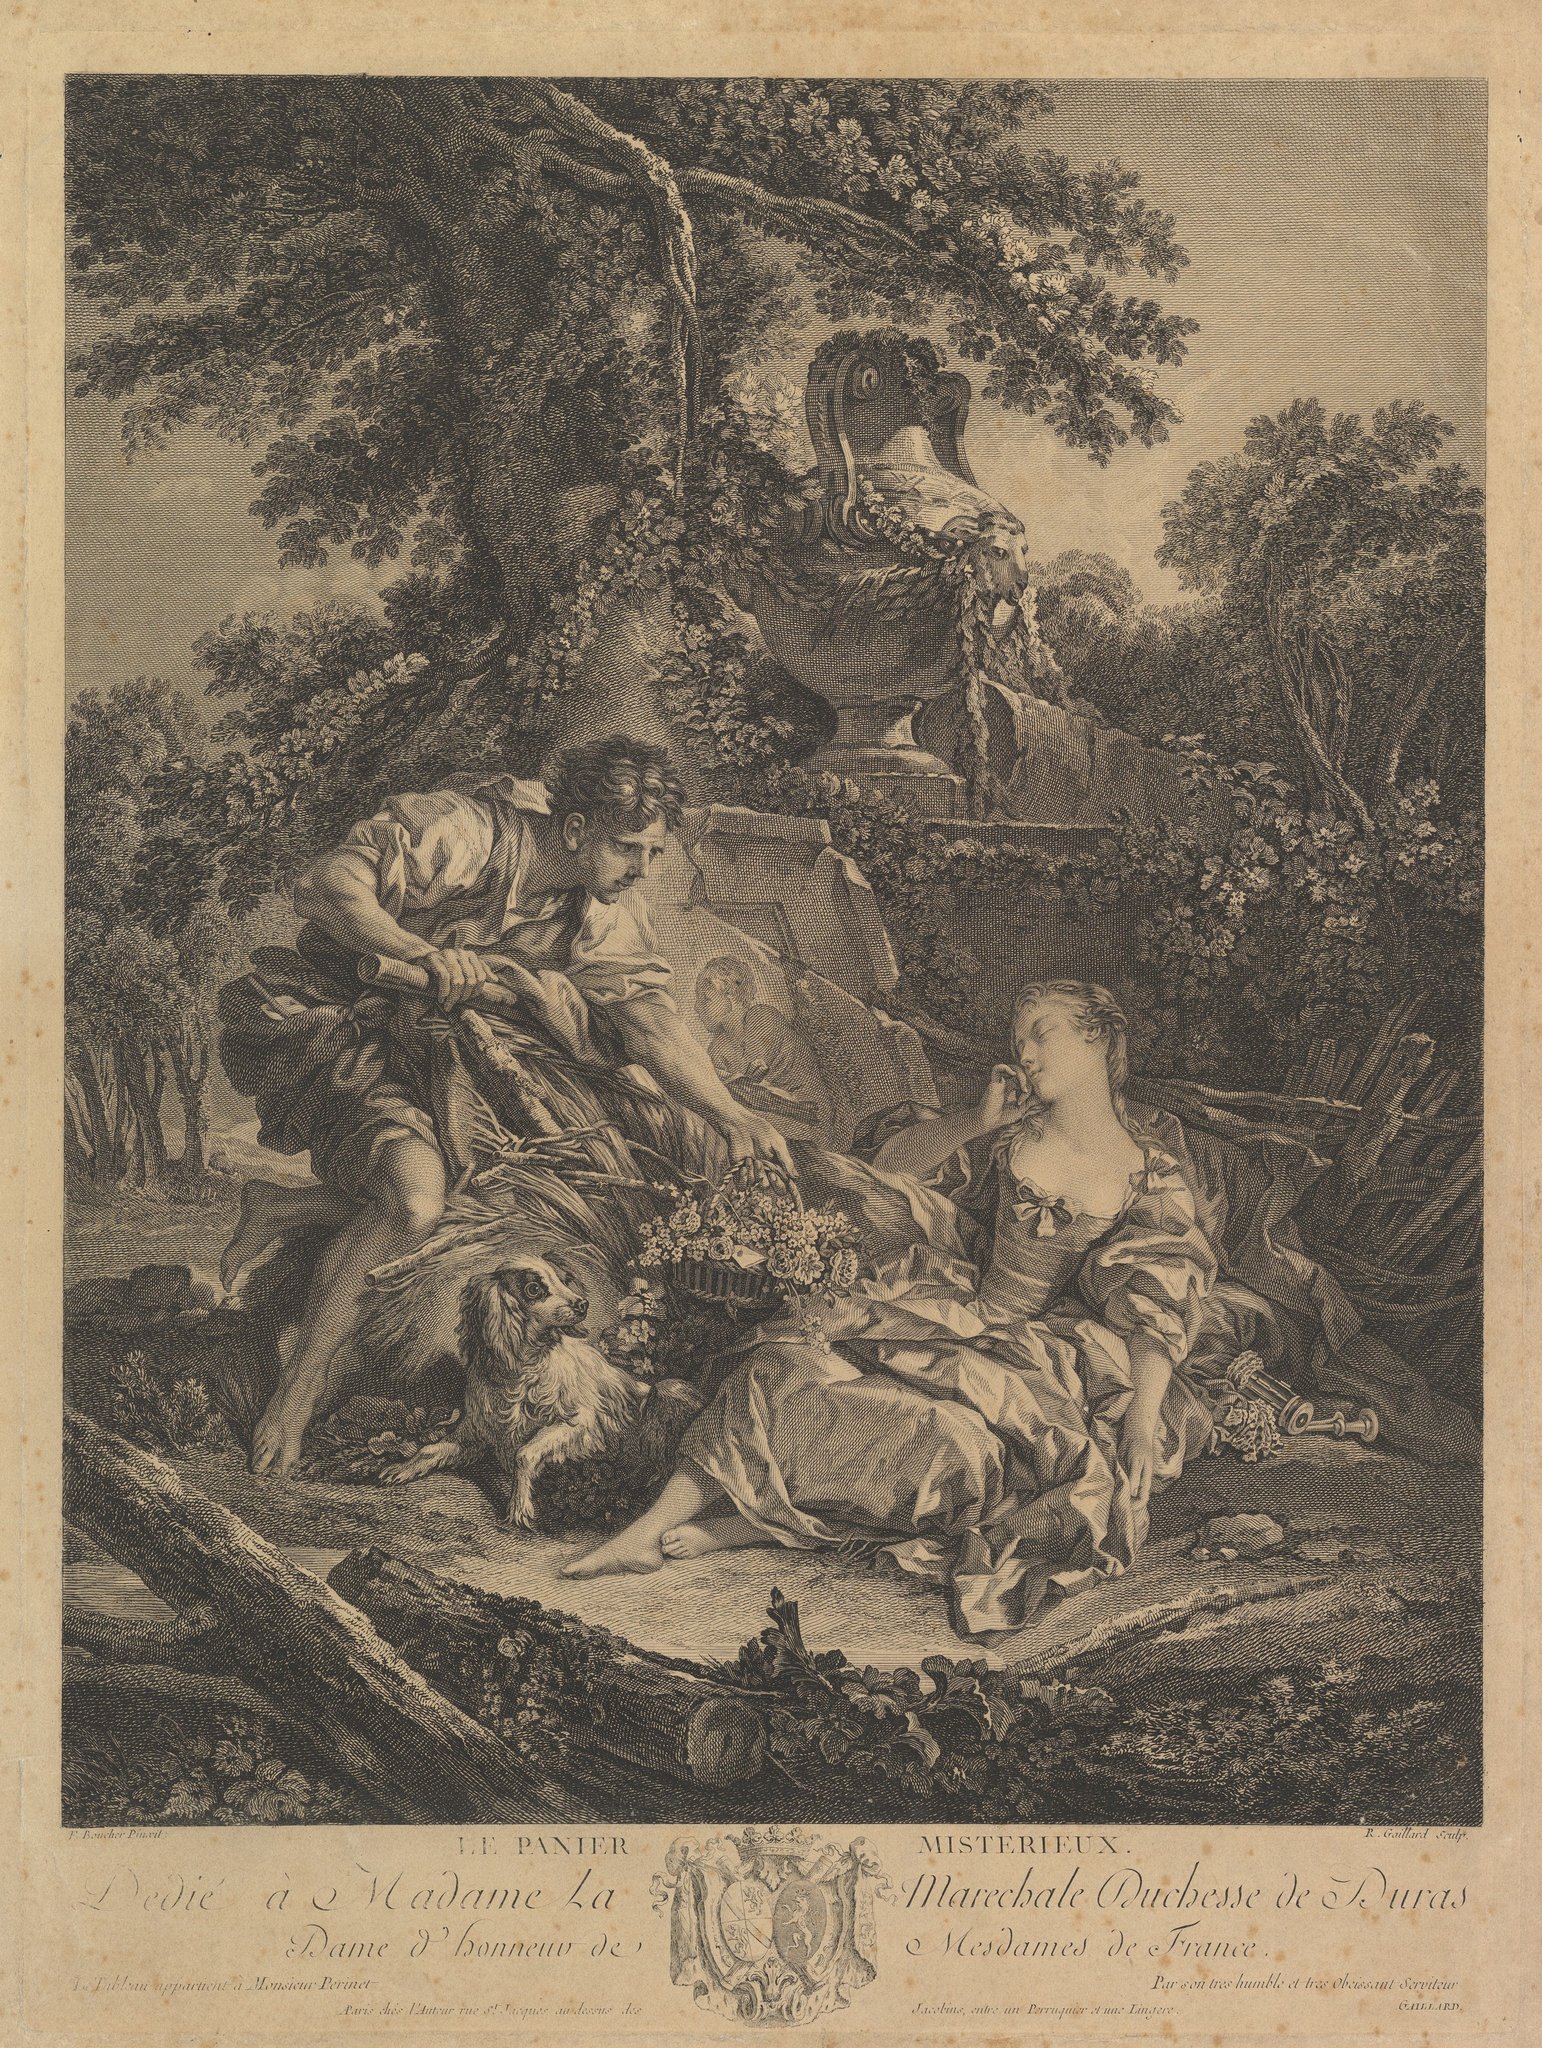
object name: print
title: Le Panier Misterieux (The Mysterious Basket)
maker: rené gaillard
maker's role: artist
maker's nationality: french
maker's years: 1714-1790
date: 1701-1800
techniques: engraving, etching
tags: men,women,dogs,trees